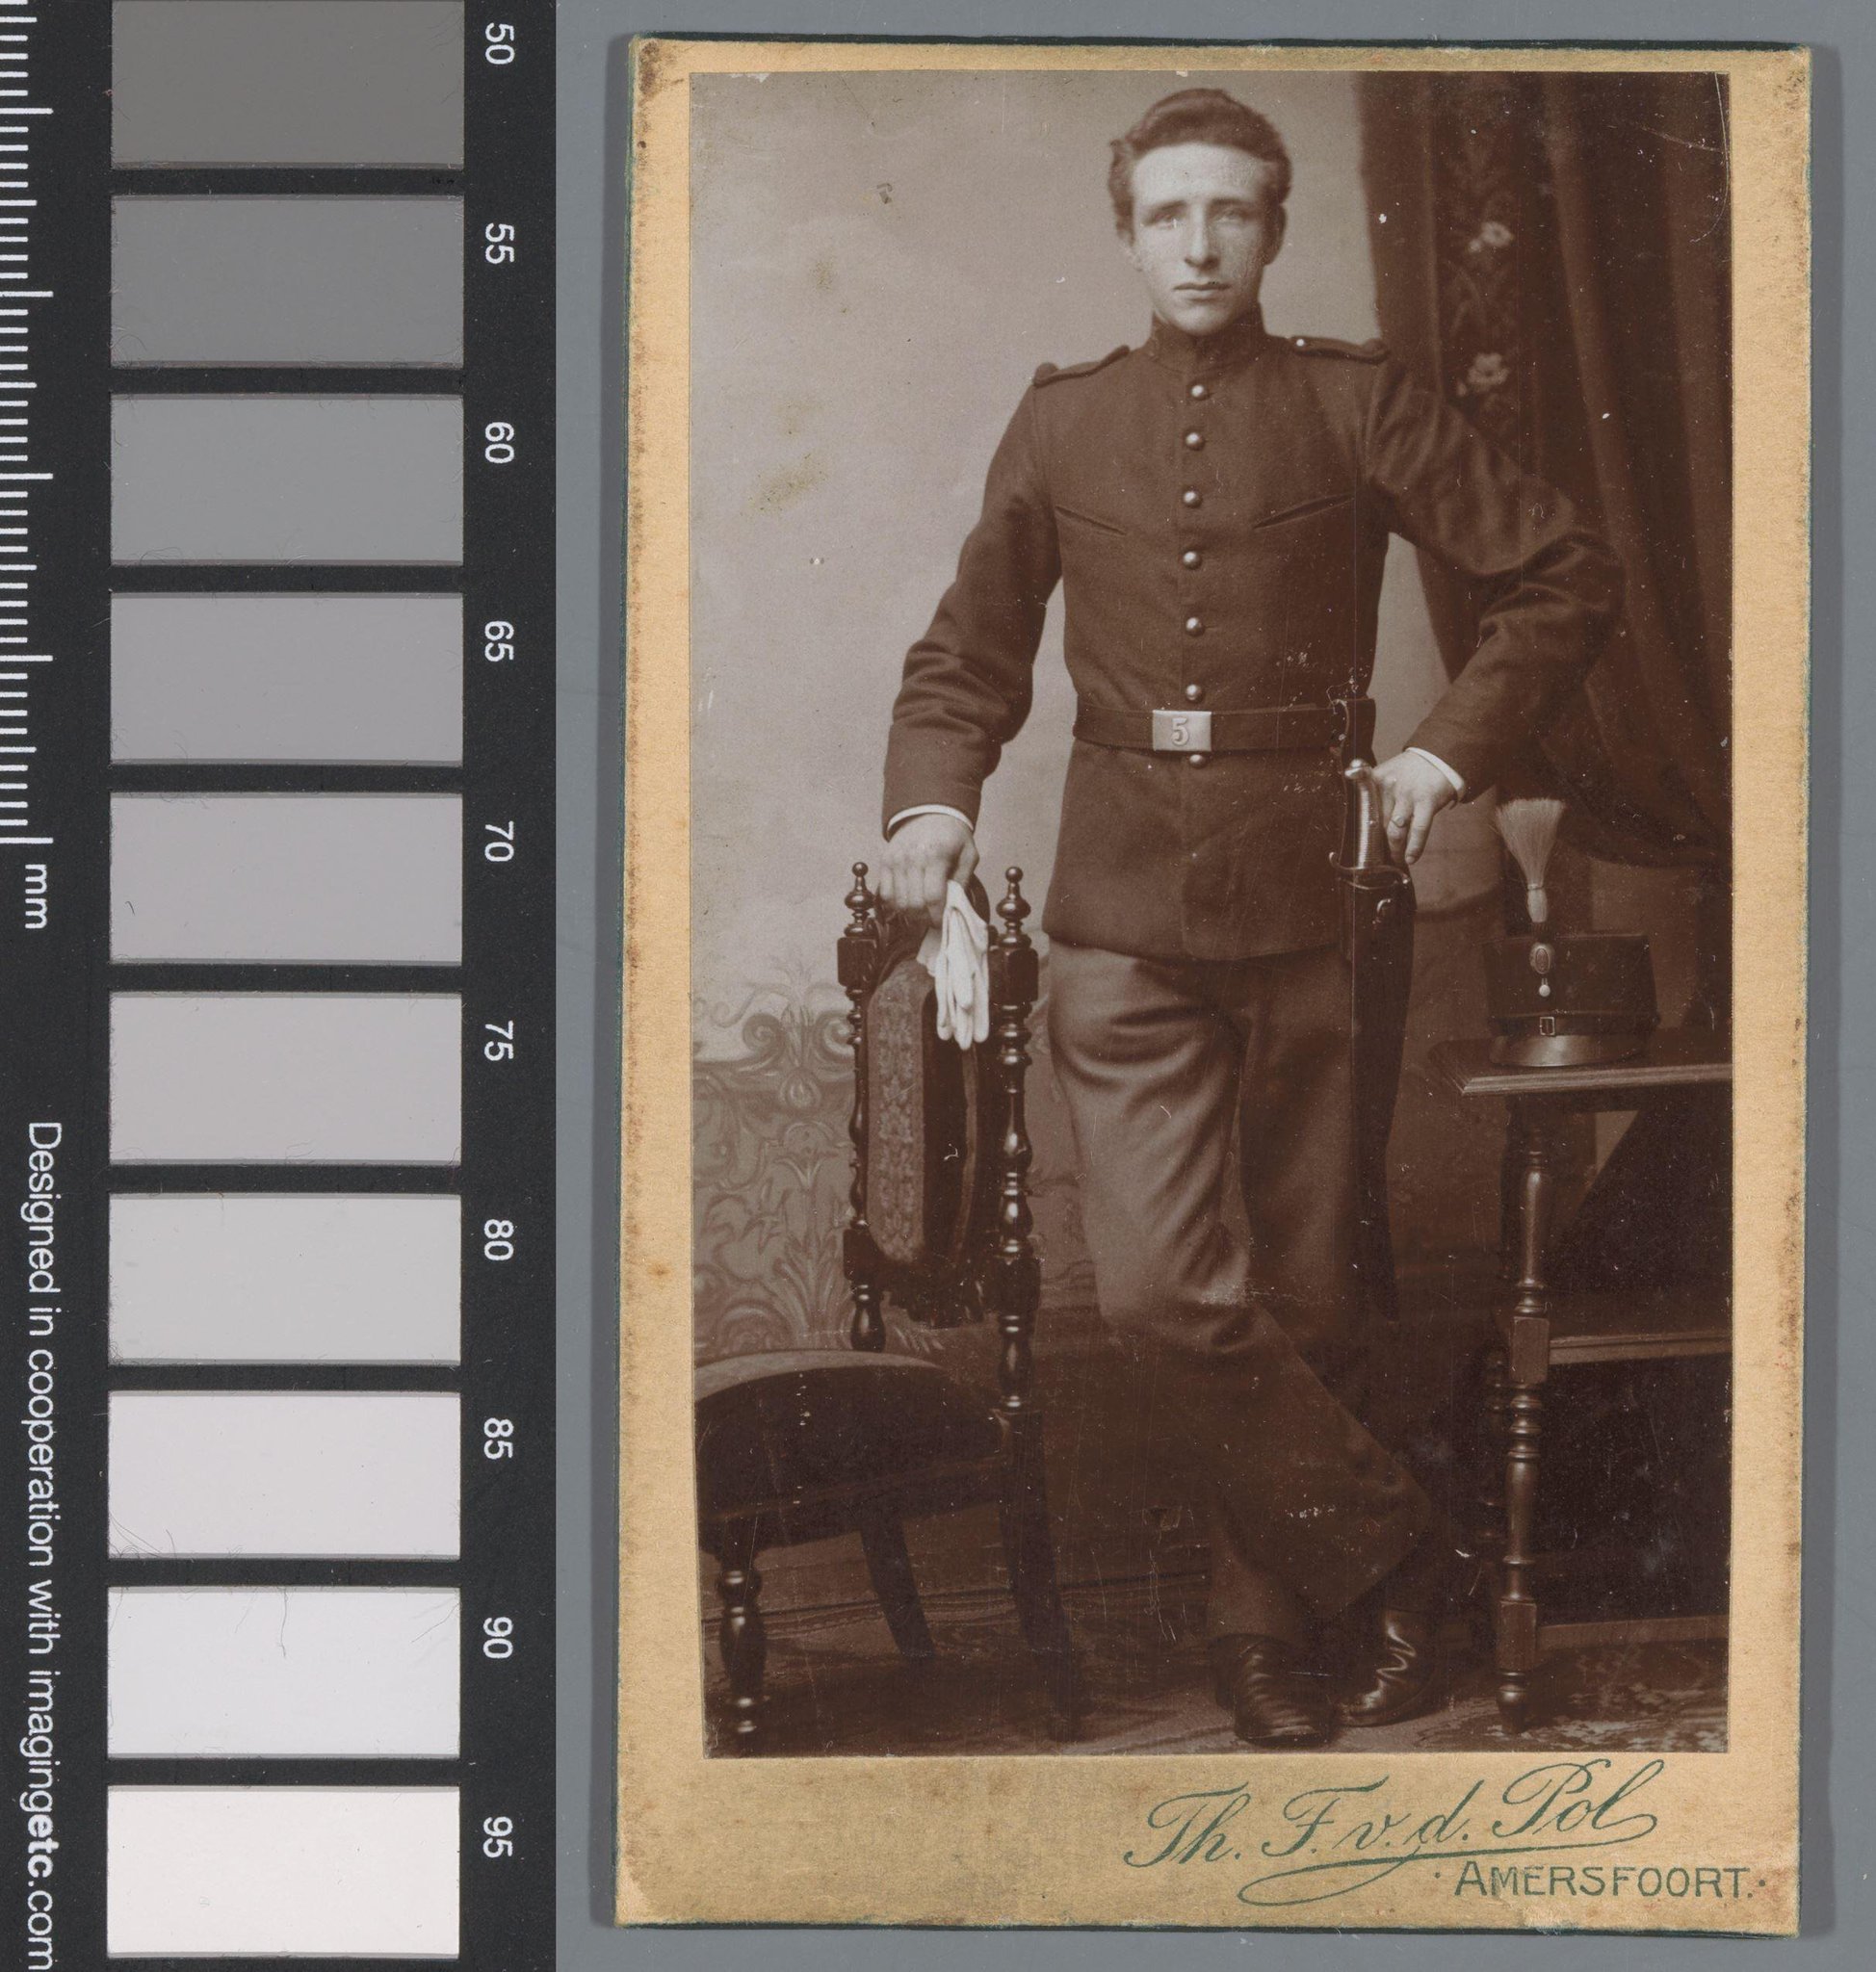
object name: carte de visite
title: Portret van een onbekende jongeman in uniform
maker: theodorus ferdinant van de pol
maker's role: fotograaf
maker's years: 1861-1953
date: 1890-1910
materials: paper, cardboard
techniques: collodion silver print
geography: amersfoort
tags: youth, adolescent, anonymous historical person portrayed, (military) uniforms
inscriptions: inscription: ‘Th. F. v.d. Pol/ Amersfoort’